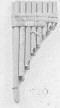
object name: panpipe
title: Panpipes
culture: bolivian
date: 1801-1900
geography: bolivia